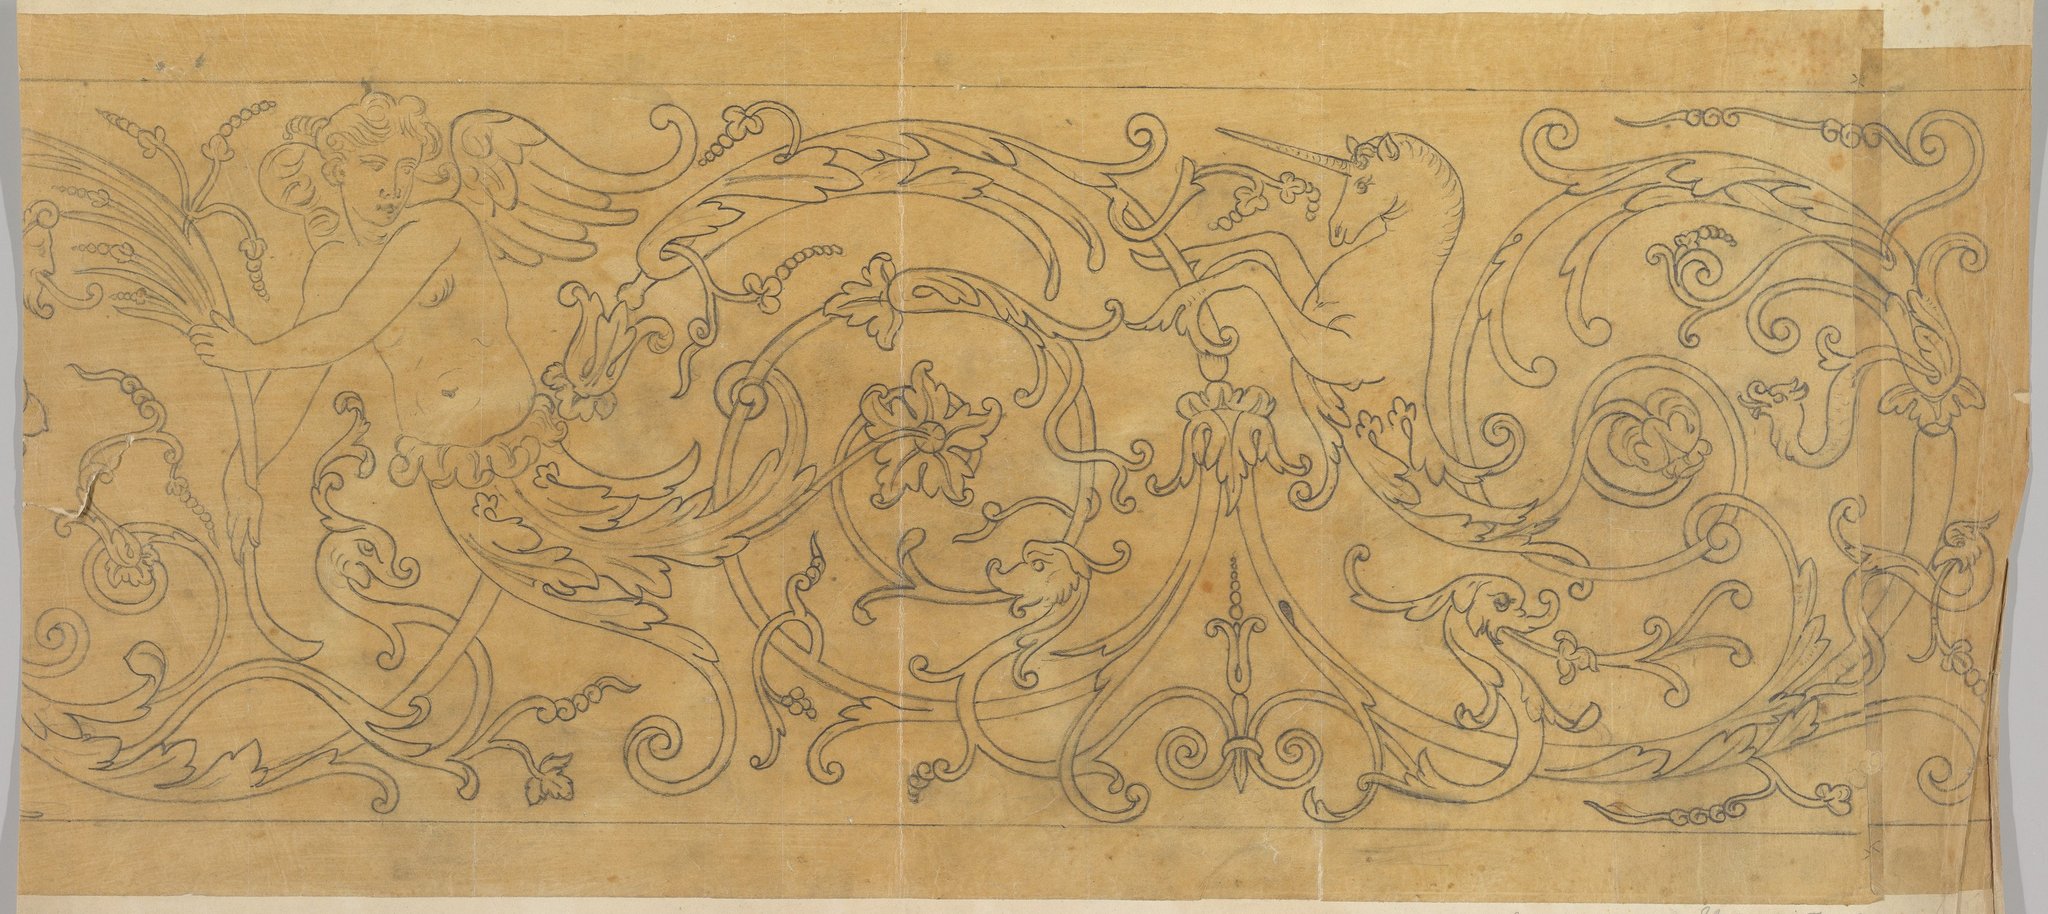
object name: drawing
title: Rinceau Border with Unicorn and Inlay on copper, Italian 18th century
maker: john gregory crace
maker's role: artist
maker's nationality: british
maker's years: 1809-1889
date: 1801-1900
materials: graphite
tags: unicorns